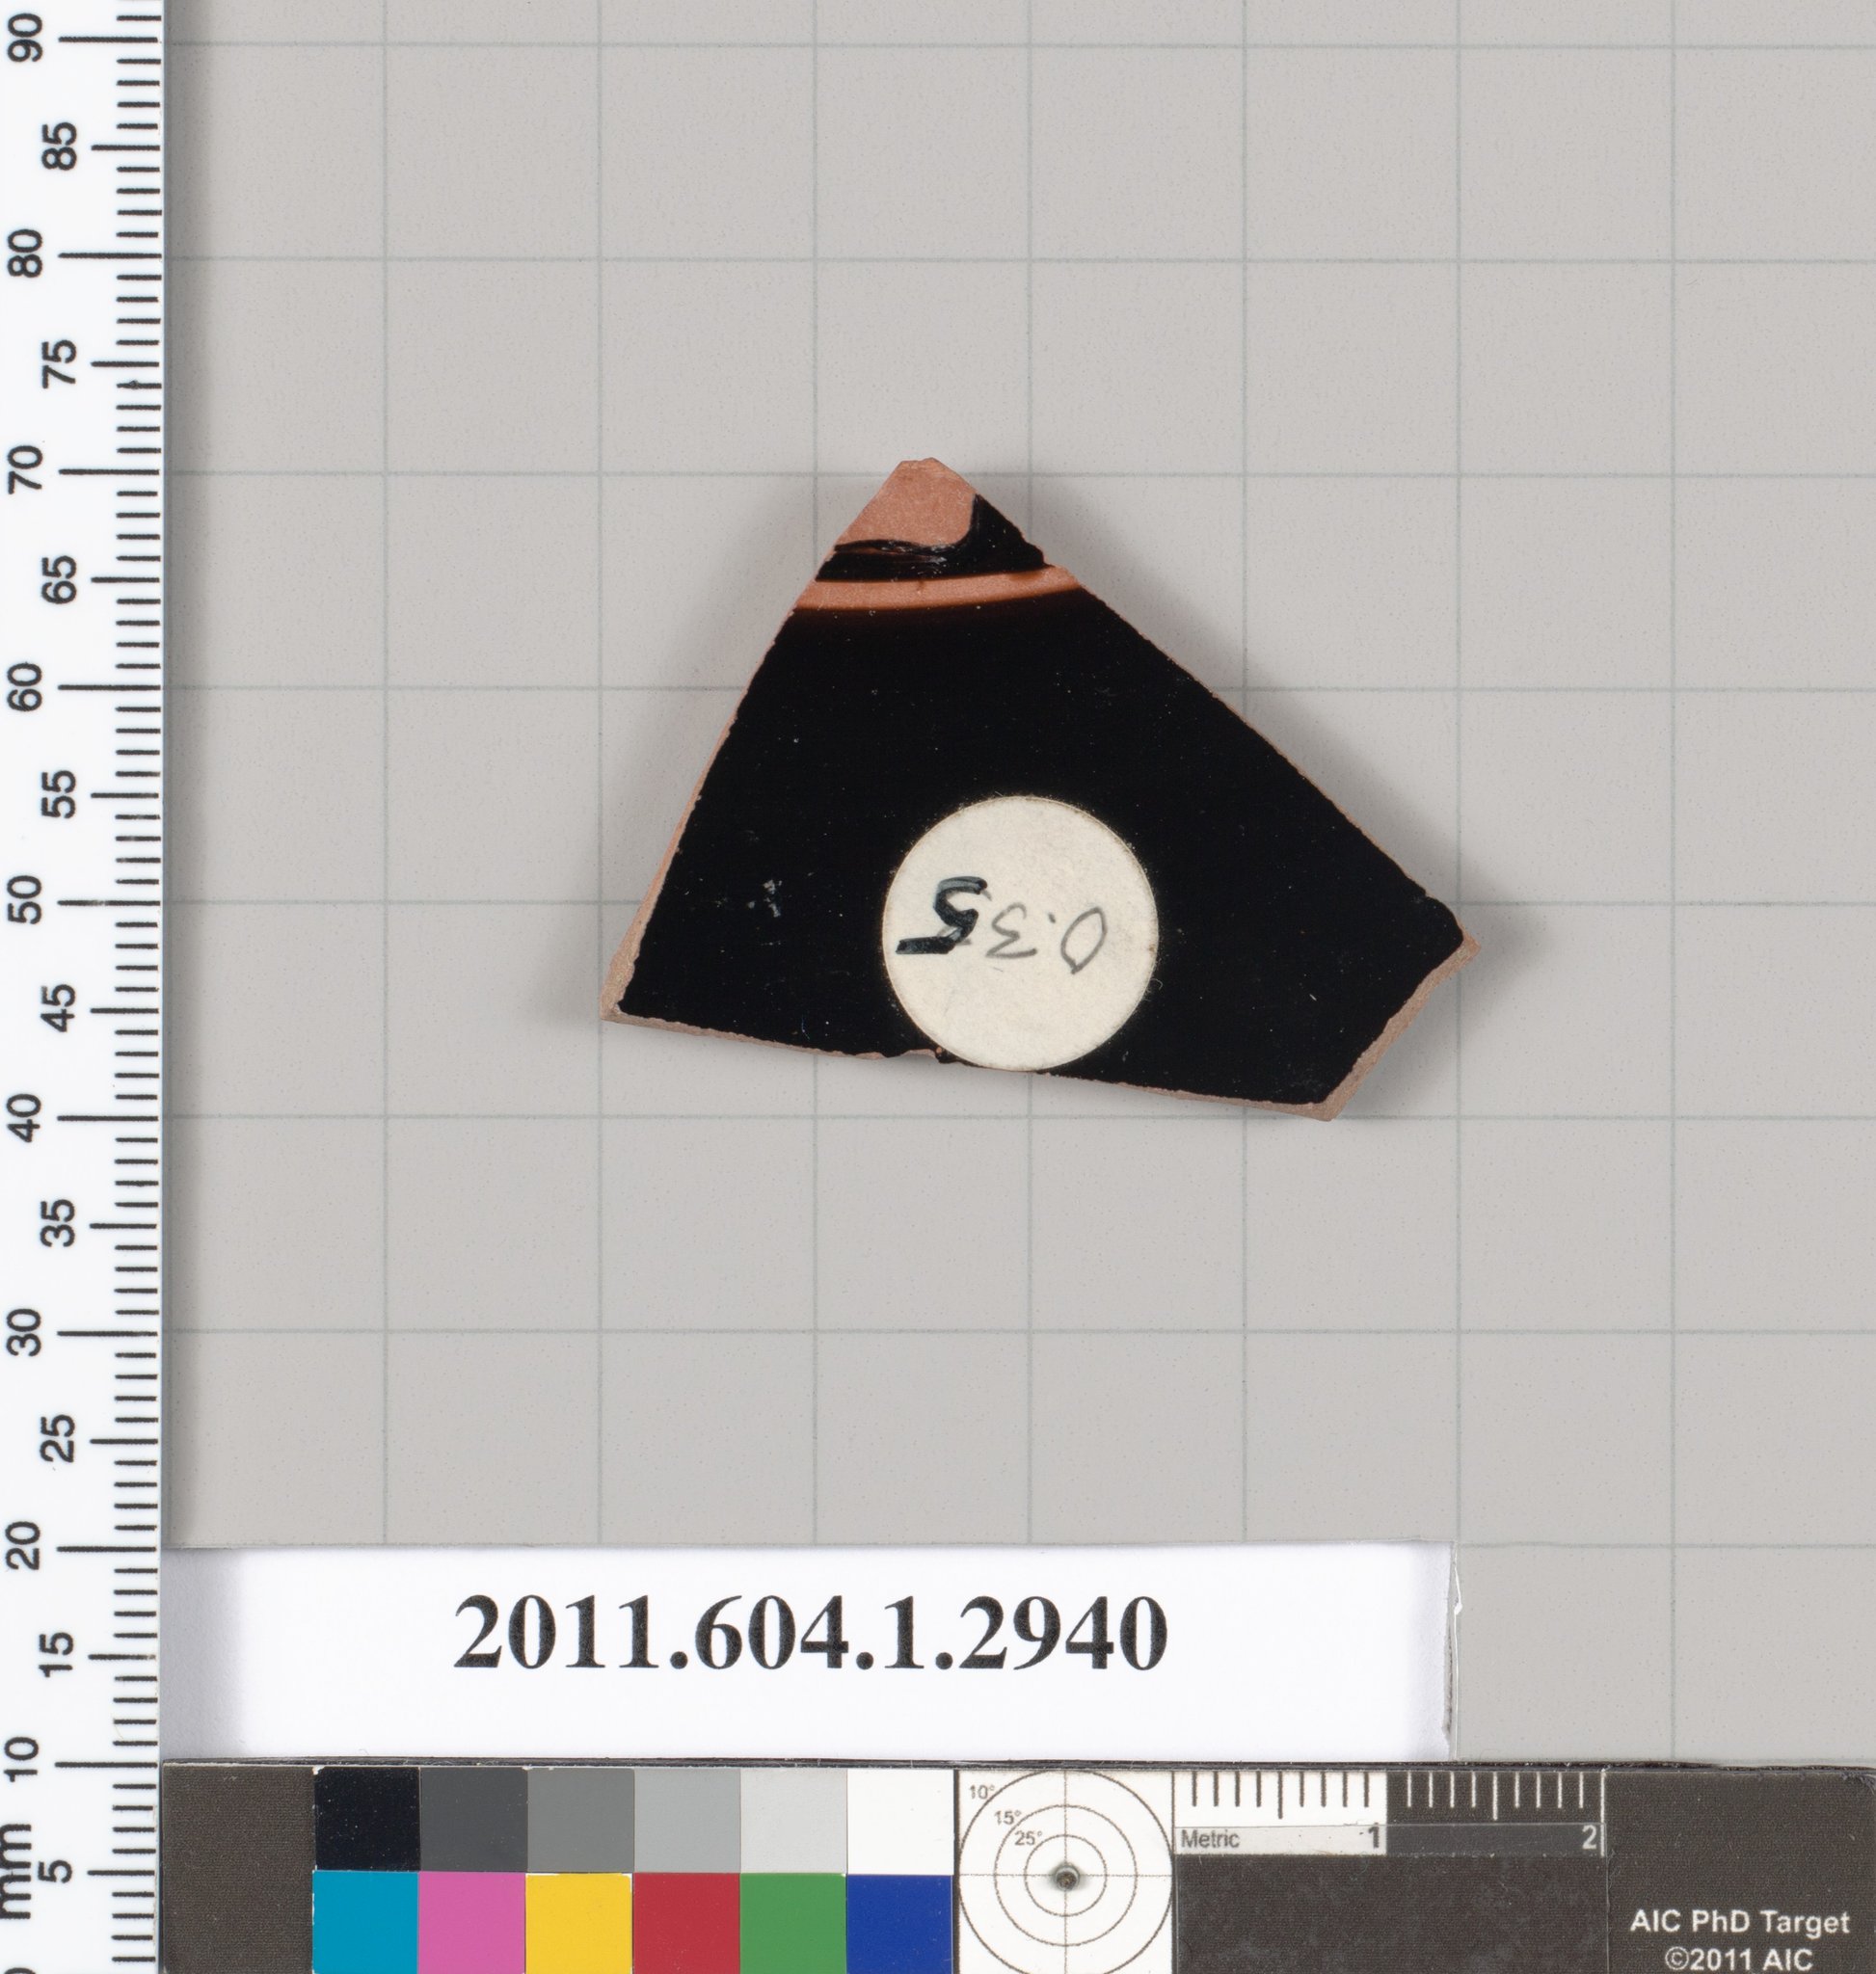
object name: kylix fragment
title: Terracotta fragment of a kylix (drinking cup)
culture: greek, attic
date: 500-476 BCE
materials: terracotta